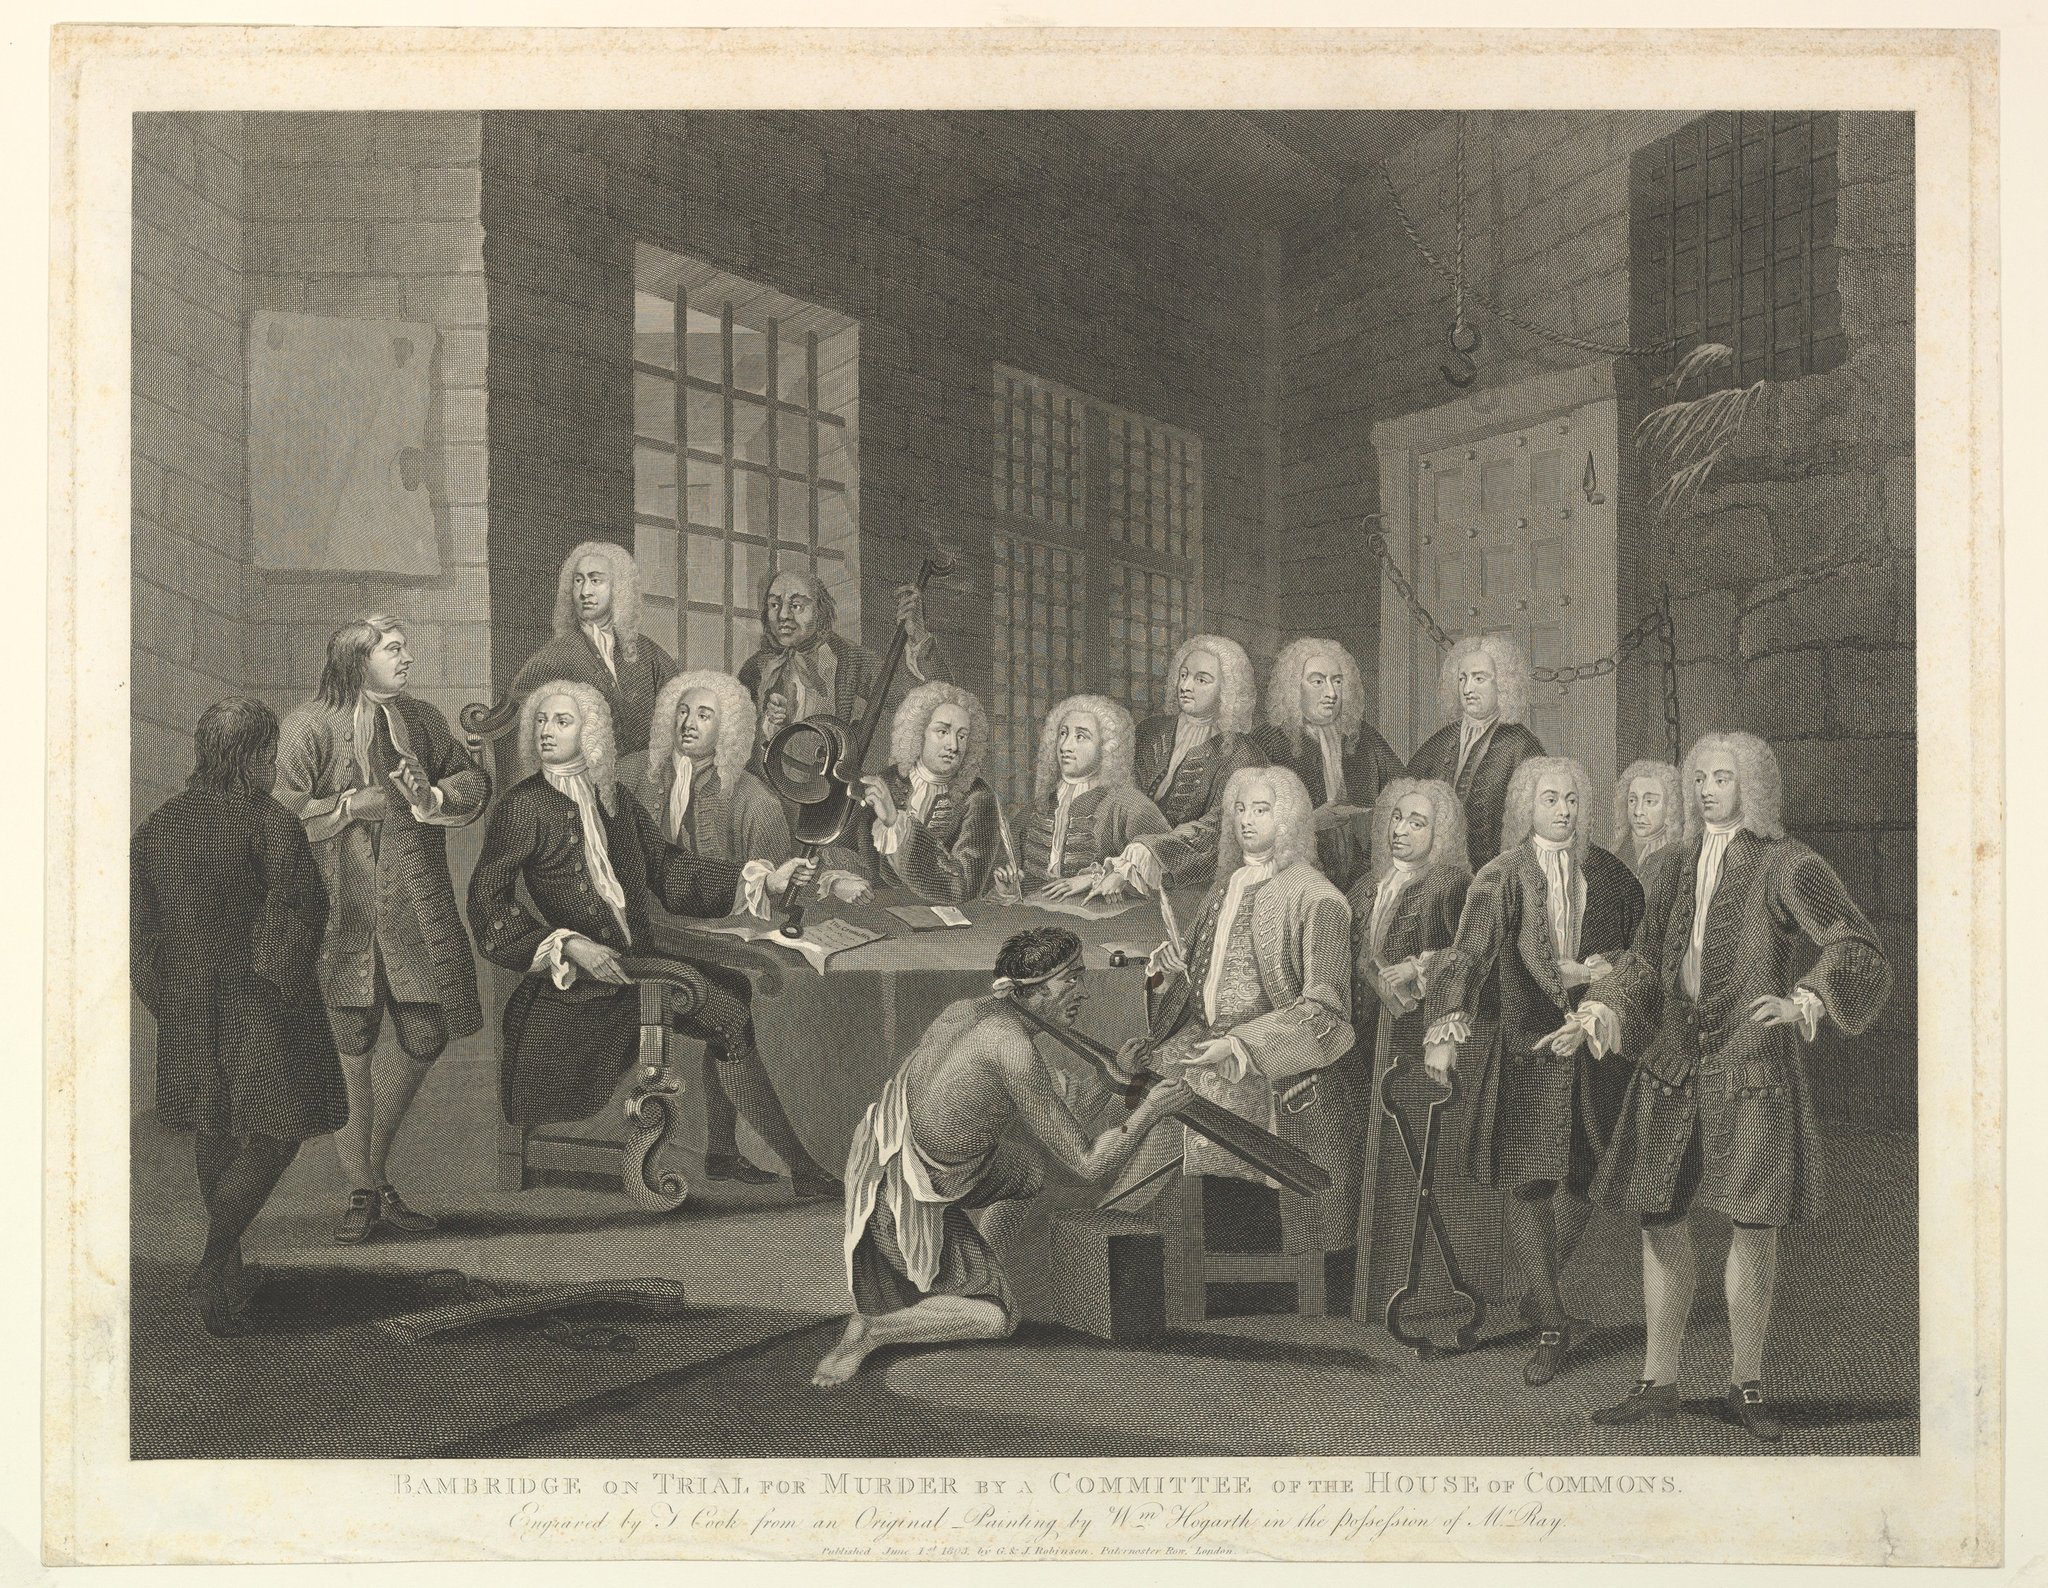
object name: print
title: Bambridge on Trial for Murder by a Committee of the House of Commons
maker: thomas cook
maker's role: engraver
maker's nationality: british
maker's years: 1744-1818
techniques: engraving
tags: men,punishment